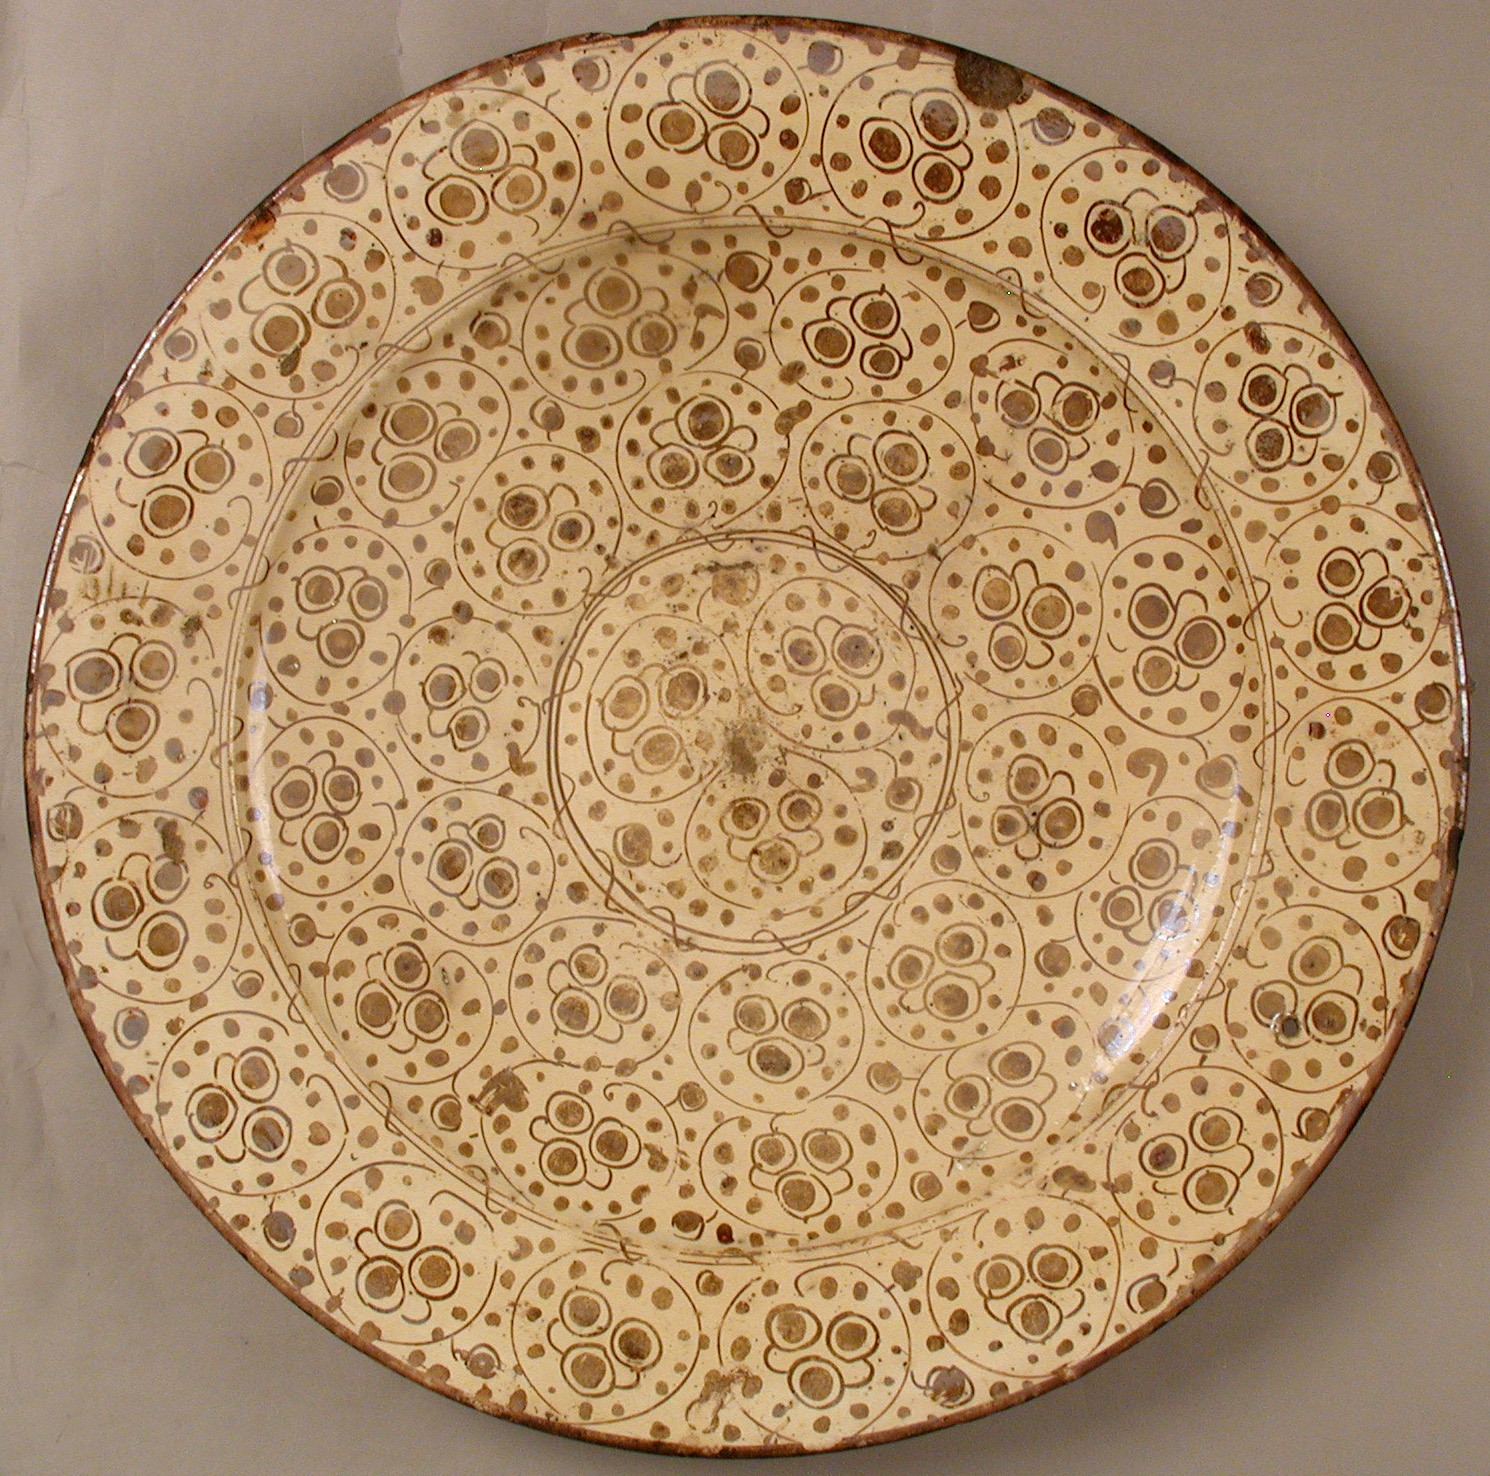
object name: dish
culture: spanish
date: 1401-1500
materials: earthenware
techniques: glazing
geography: spain